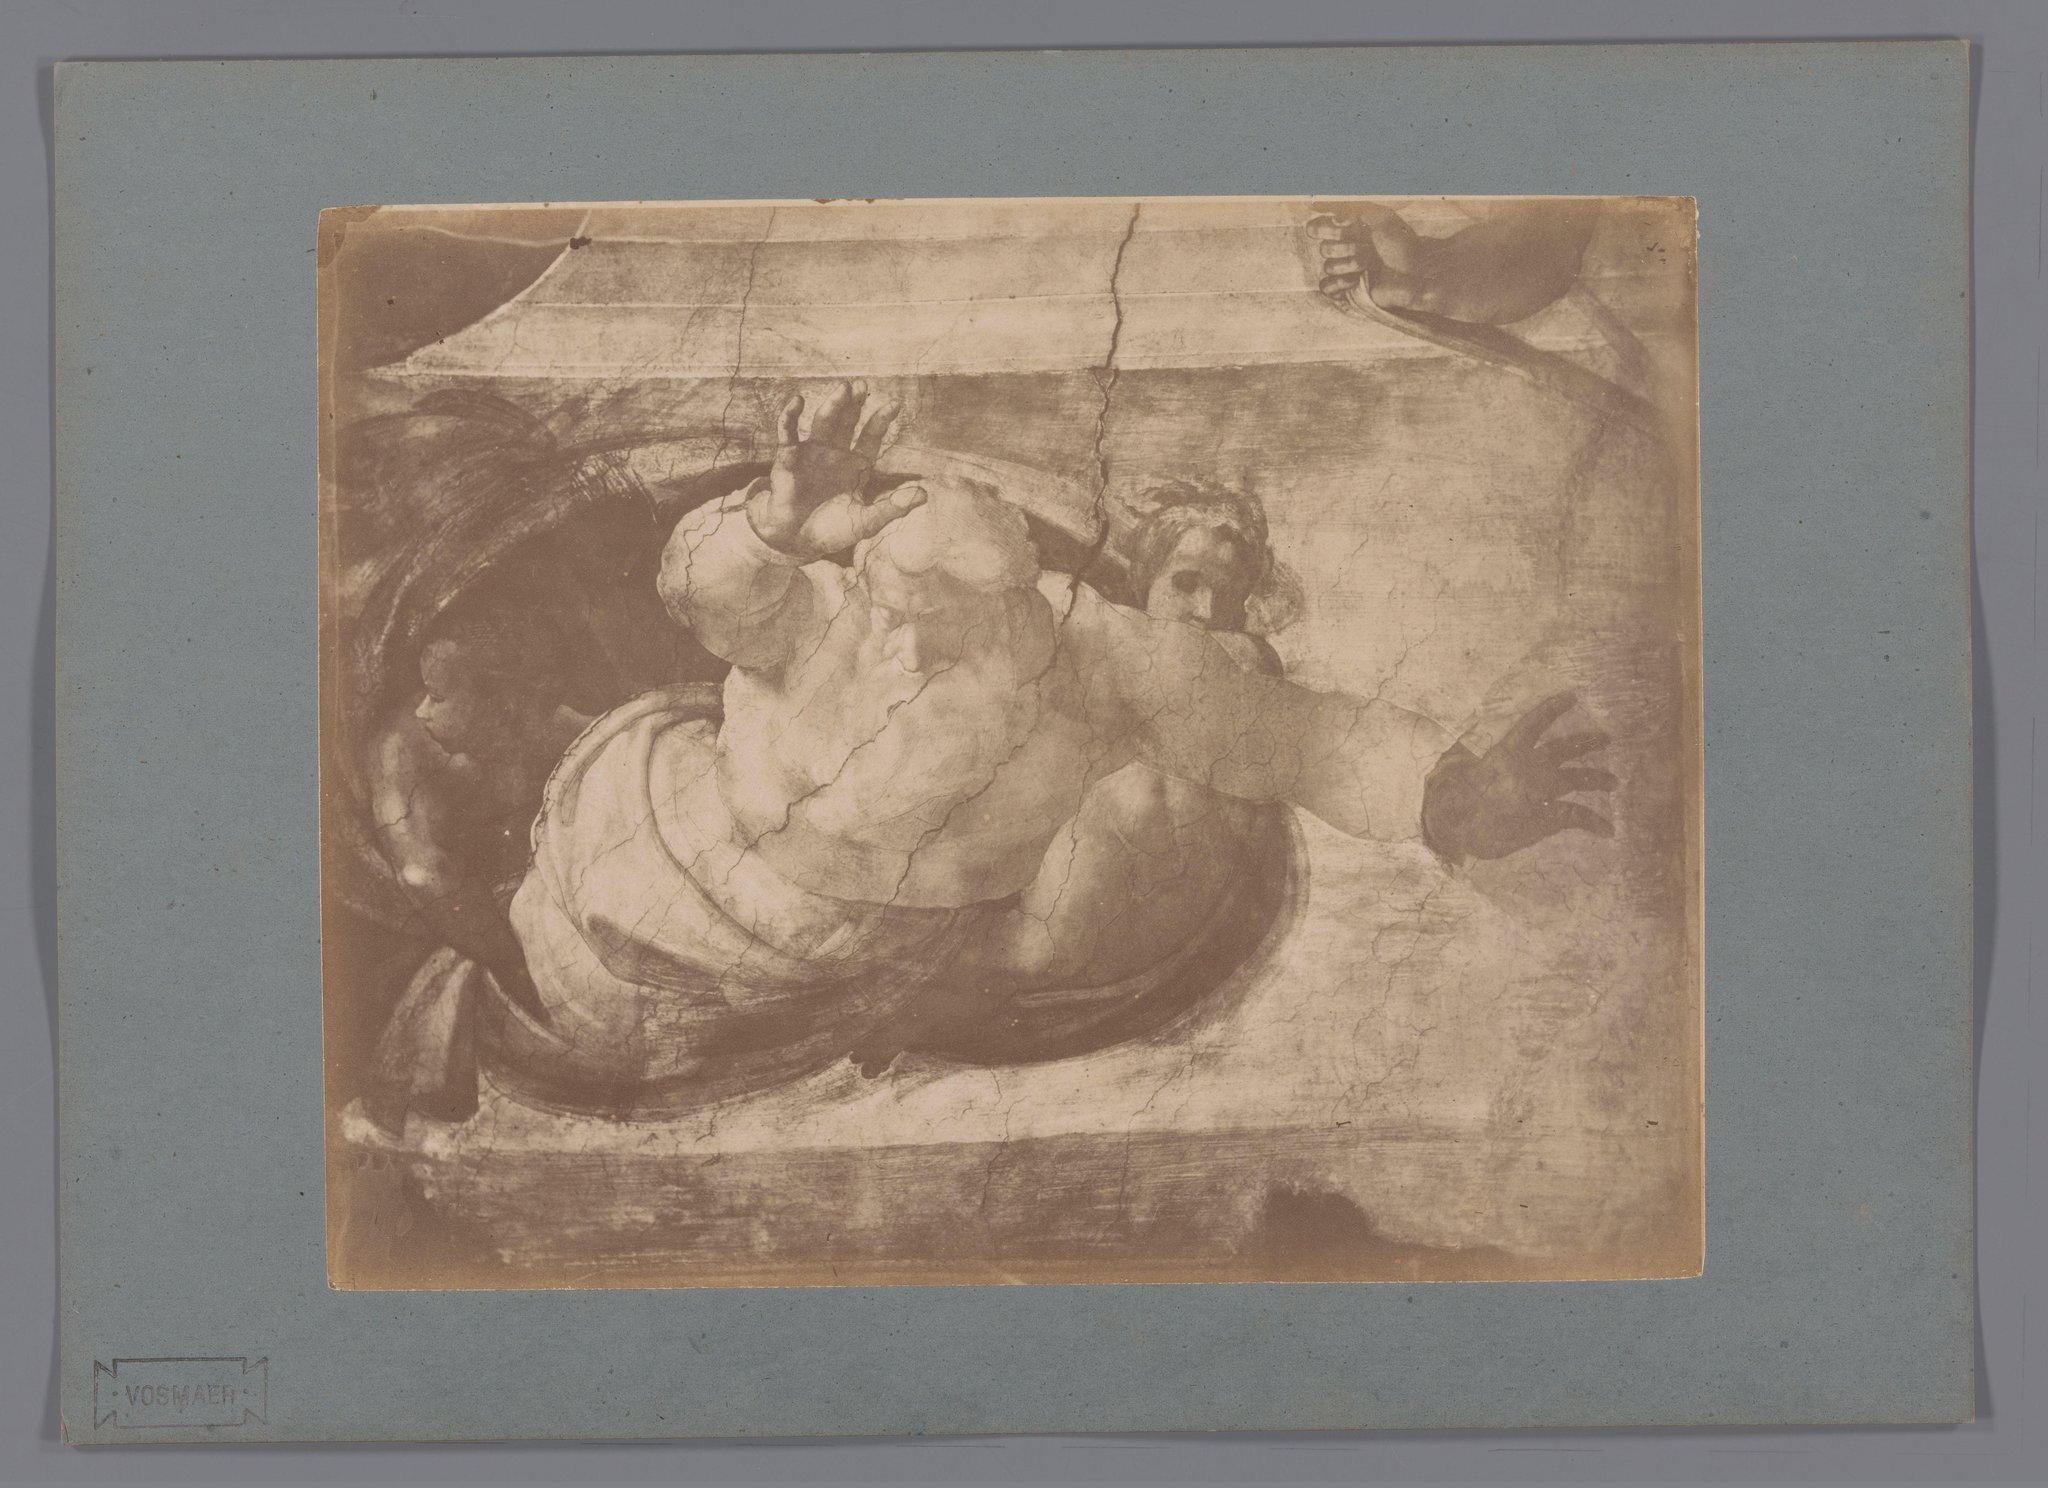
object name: reproduction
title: Fotoreproductie van het fresco De scheiding van water en land door Michelangelo in de Sixtijnse kapel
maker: Anonymous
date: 1851-1900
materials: cardboard, paper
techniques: albumen print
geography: vatican city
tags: picture, painting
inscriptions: collector's mark: ‘VOSMAER’